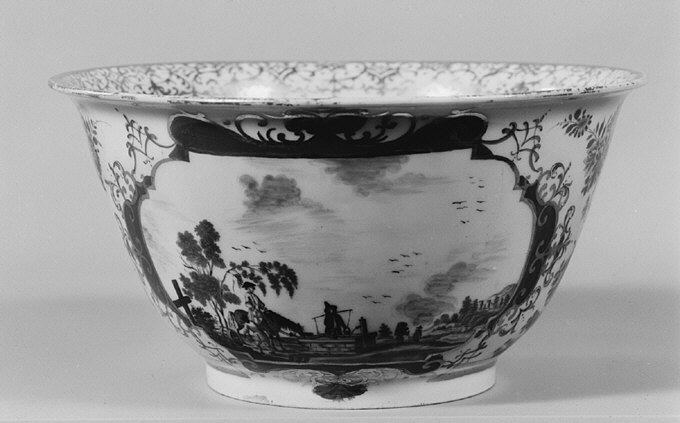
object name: bowl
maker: meissen manufactory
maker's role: manufactory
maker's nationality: german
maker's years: 1710-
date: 1730-1735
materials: hard paste porcelain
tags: men